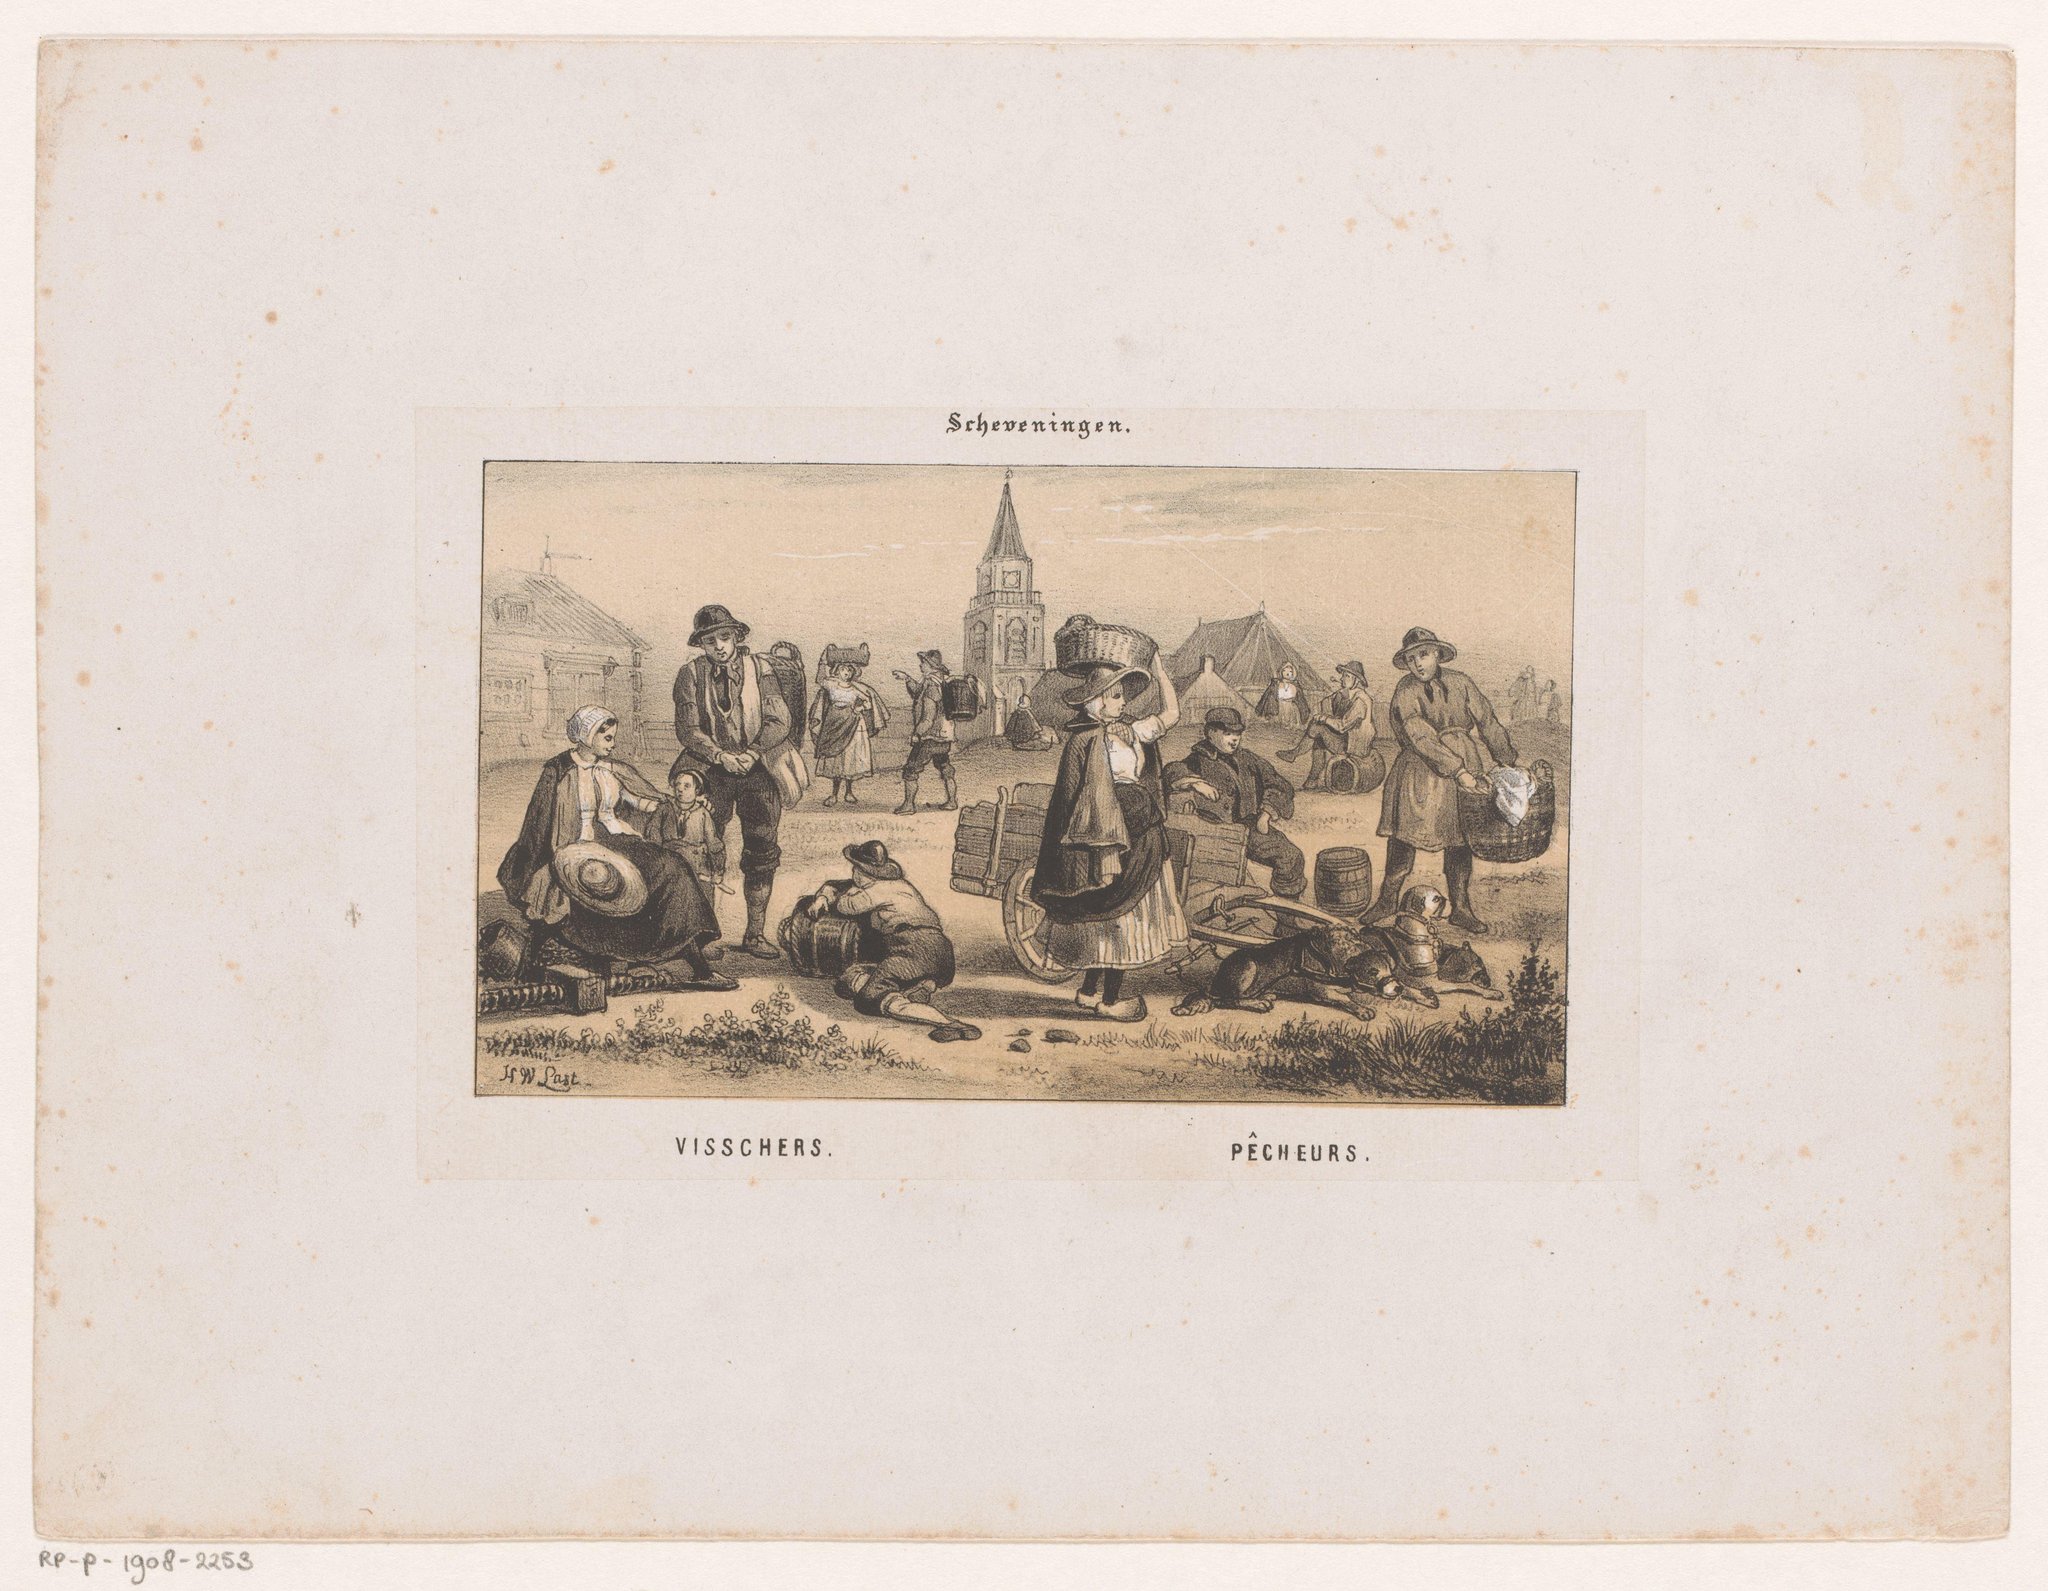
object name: print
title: Vissers in Scheveningen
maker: hendrik wilhelmus last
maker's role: print maker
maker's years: 1817-1873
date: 1827-1873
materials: paper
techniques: tone lithography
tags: four-wheeled vehicle drawn by two animals, fisherman, carrying something on the head or on the shoulders, dog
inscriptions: collector's mark: Lugt 2228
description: Mannen en vrouwen lopen rond met manden op hun hoofd of in hun armen. Een man zit bij een hondenkar. In de achtergrond een kerk.